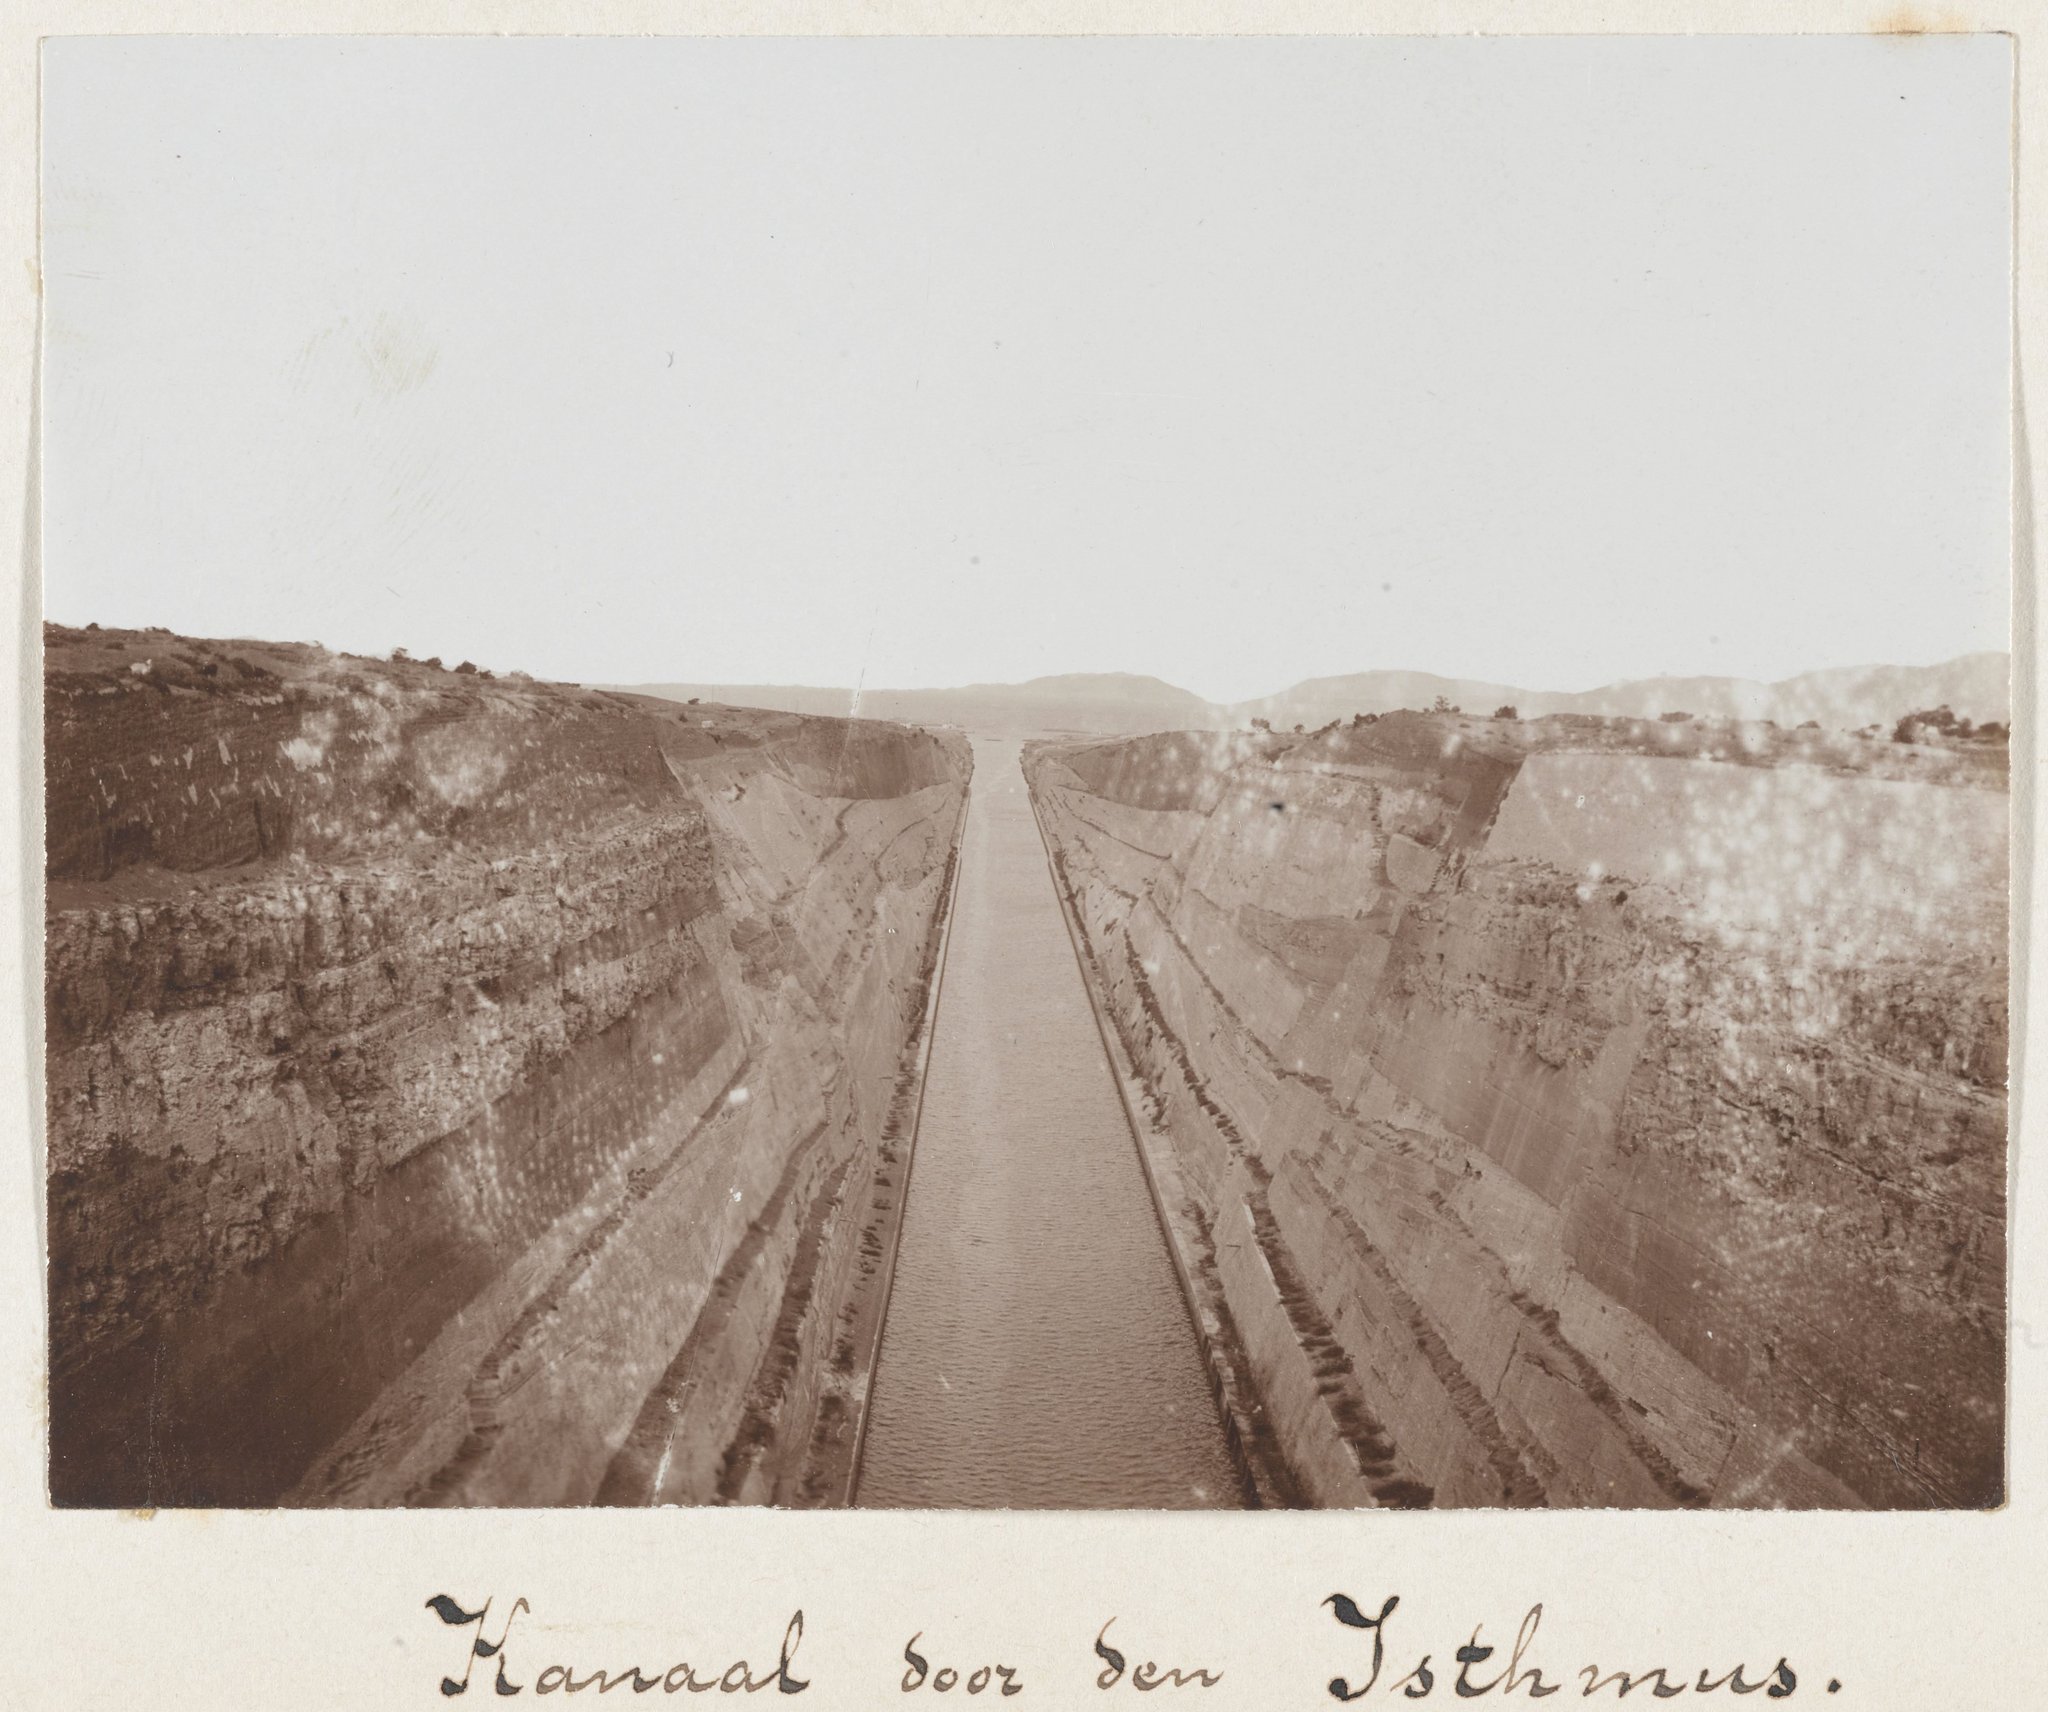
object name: photograph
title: Kanaal door de Isthmus of landengte van Korinthe, verbinding tussen de Korinthische en de Saronische Golf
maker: johannes lodewijk heldring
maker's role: fotograaf, predikant, schrijver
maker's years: 1852-1923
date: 1898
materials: paper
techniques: collodion silver print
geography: corinth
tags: straits, narrows